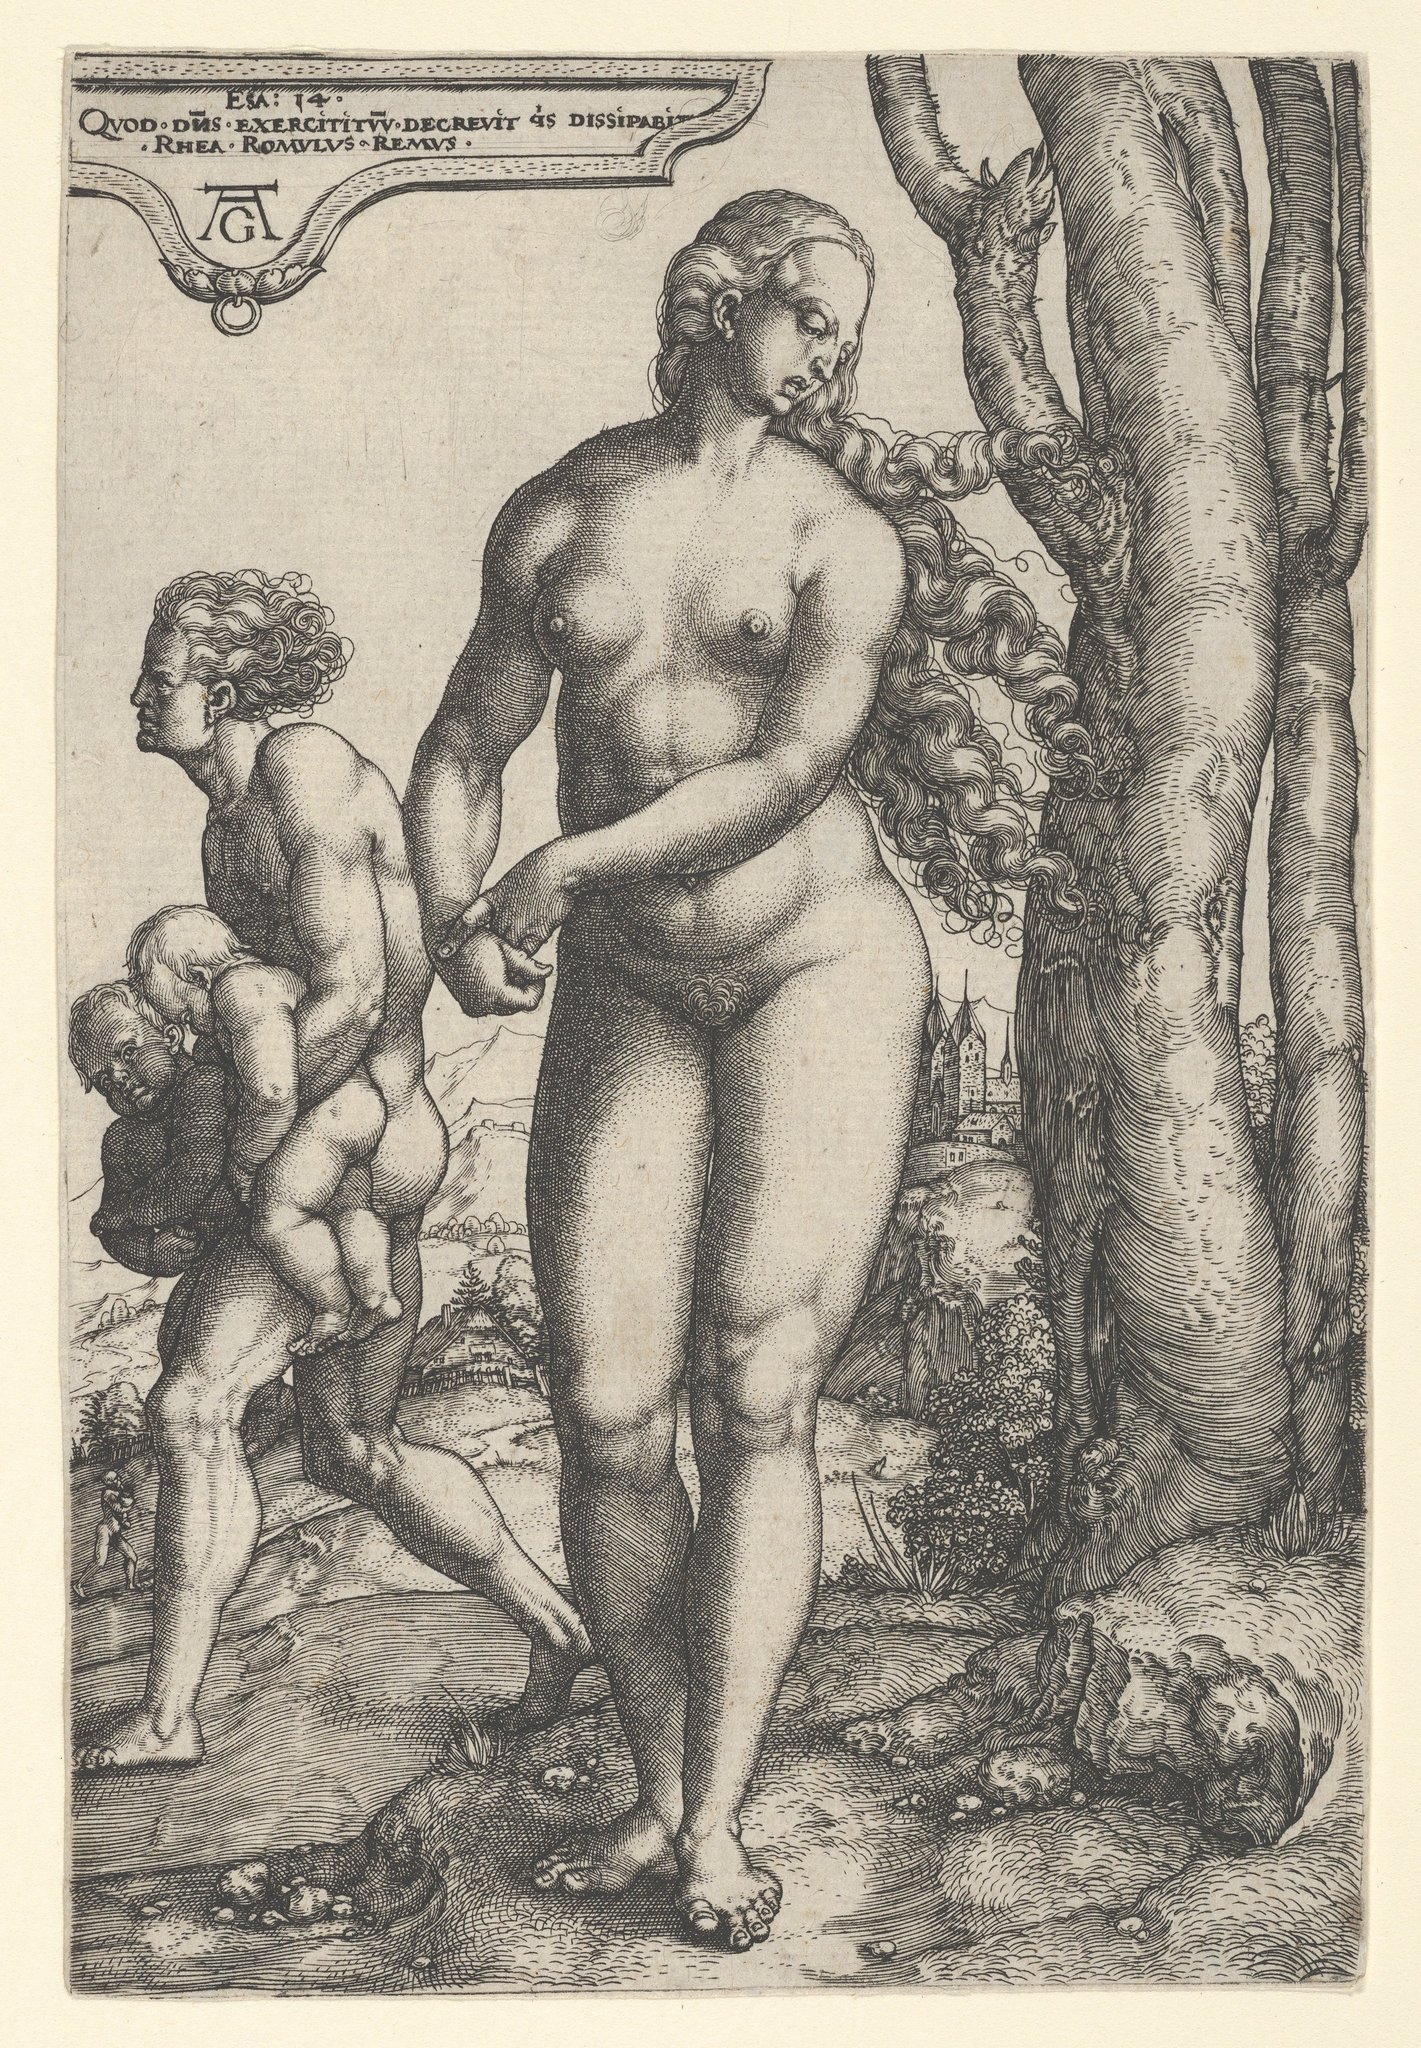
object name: print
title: Rhea Silvia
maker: heinrich aldegrever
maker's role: artist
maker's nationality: german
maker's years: 1502-1561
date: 1532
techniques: engraving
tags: mythology,infants,female nudes